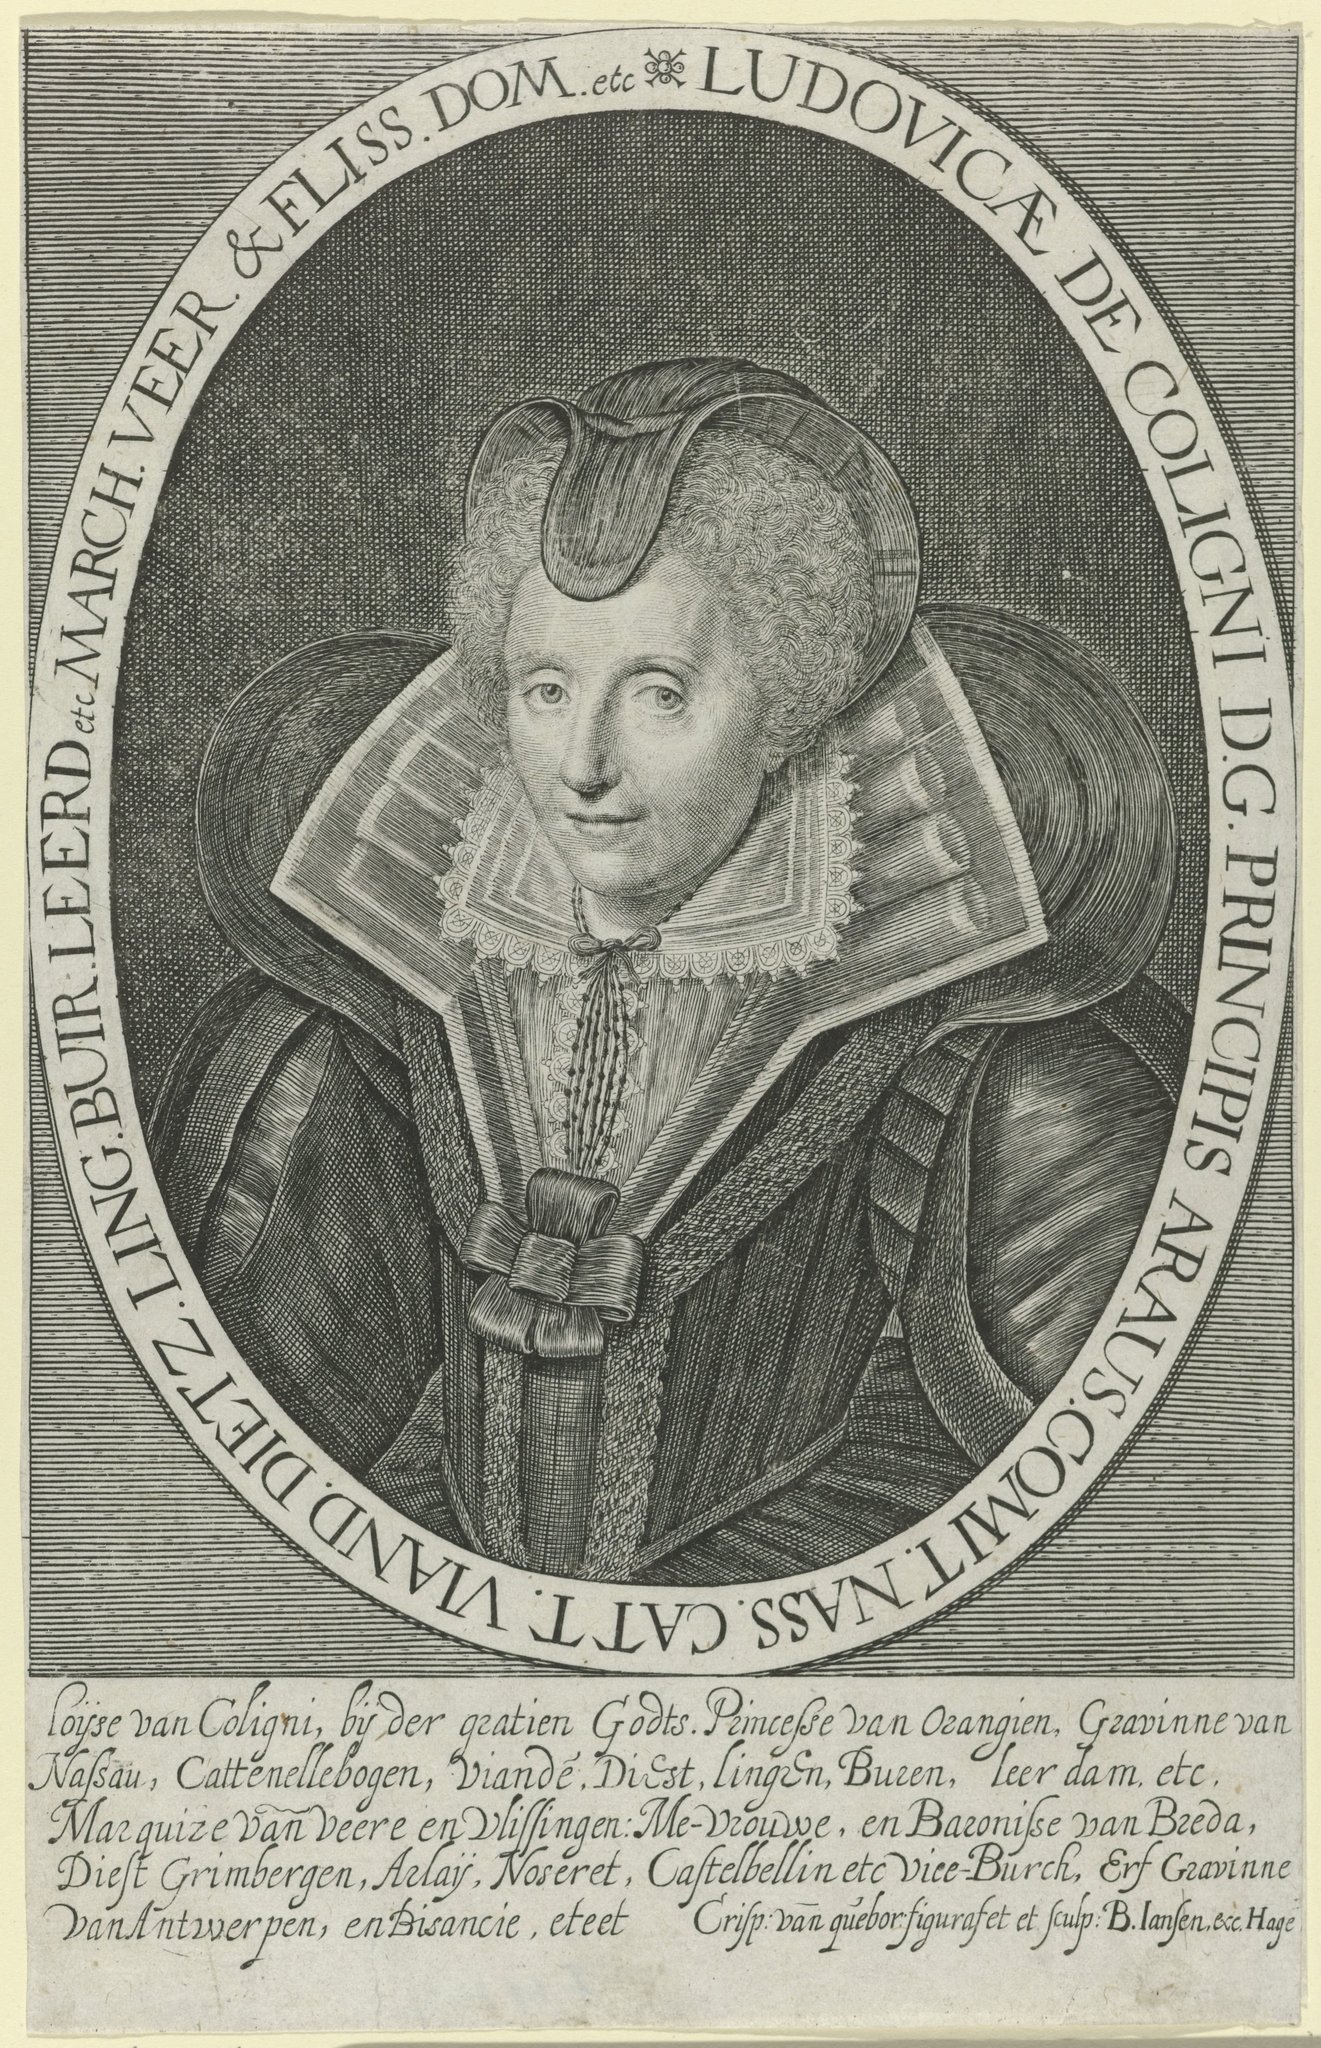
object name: print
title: Portret van Louise de Coligny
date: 1586-1629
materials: paper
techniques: engraving, etching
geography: the hague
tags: louise de coligny, neck-gear: collar (+ women's clothes)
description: Portret van Louise in een ovaal met randschrift. In de ondermarge vijf regels Nederlandse tekst.